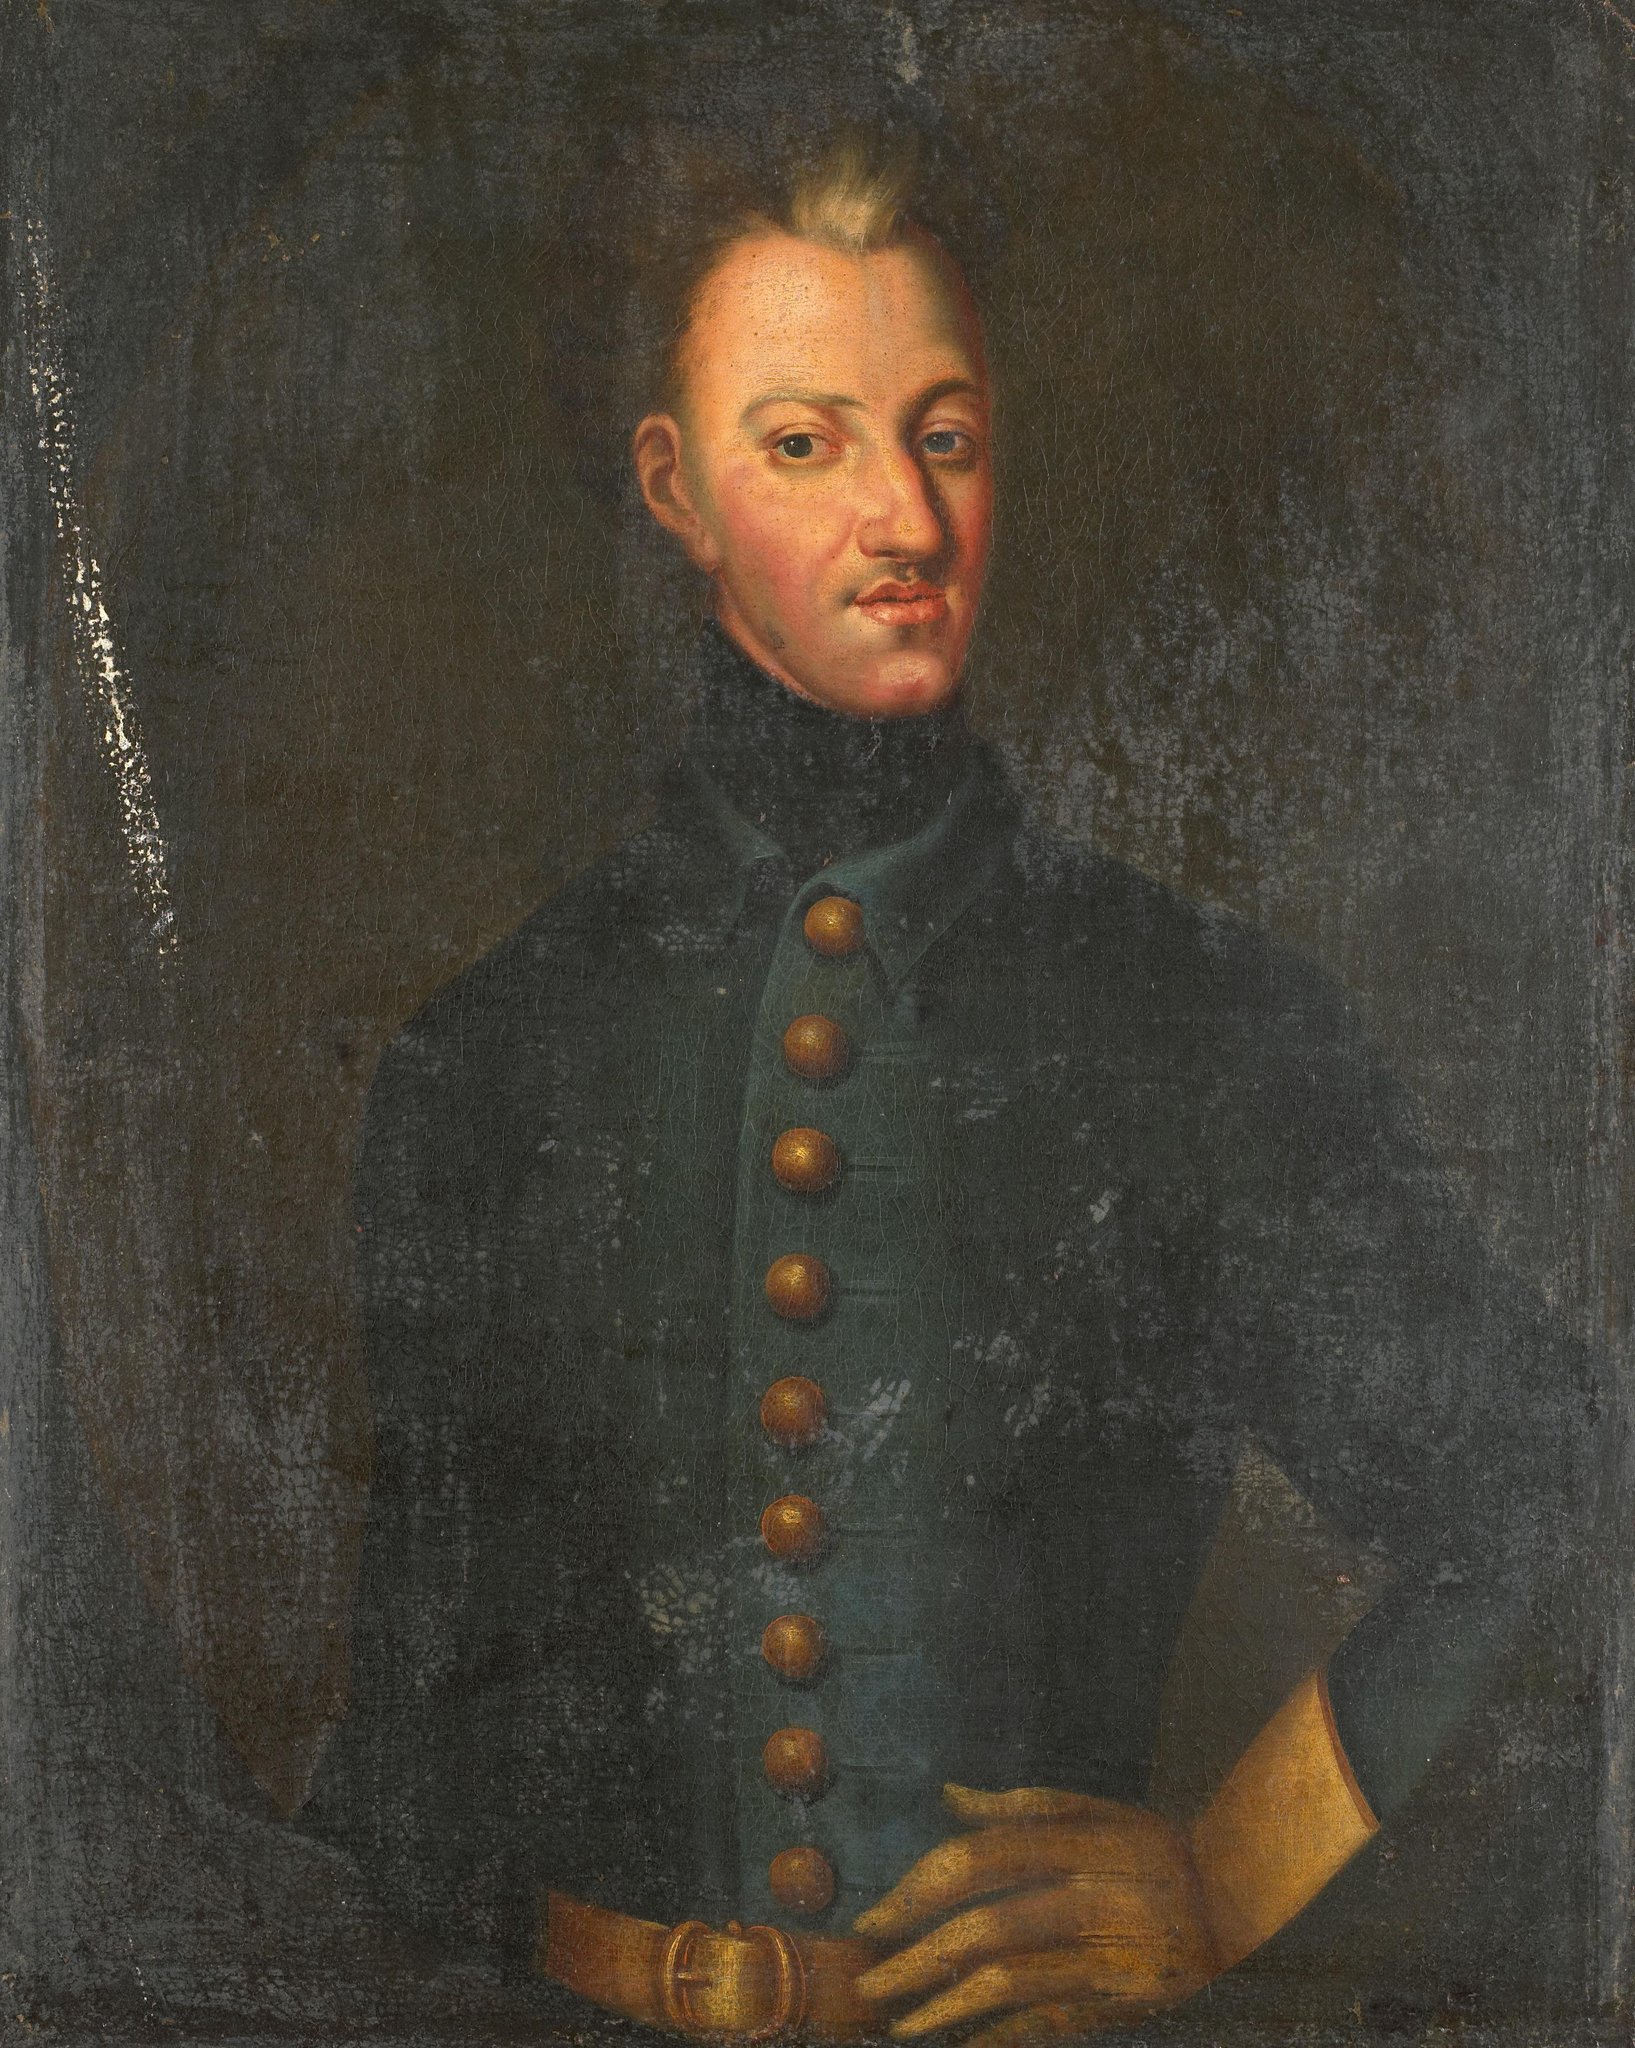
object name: painting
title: Charles XII (1682-1718), King of Sweden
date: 1700-1750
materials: canvas, oil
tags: historical persons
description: Portret van Karel XII, koning van Zweden. Ten halven lijve, staand, met de linkerhand in de zij. Kopie door een onbekende naar het origineel van David von Krafft.